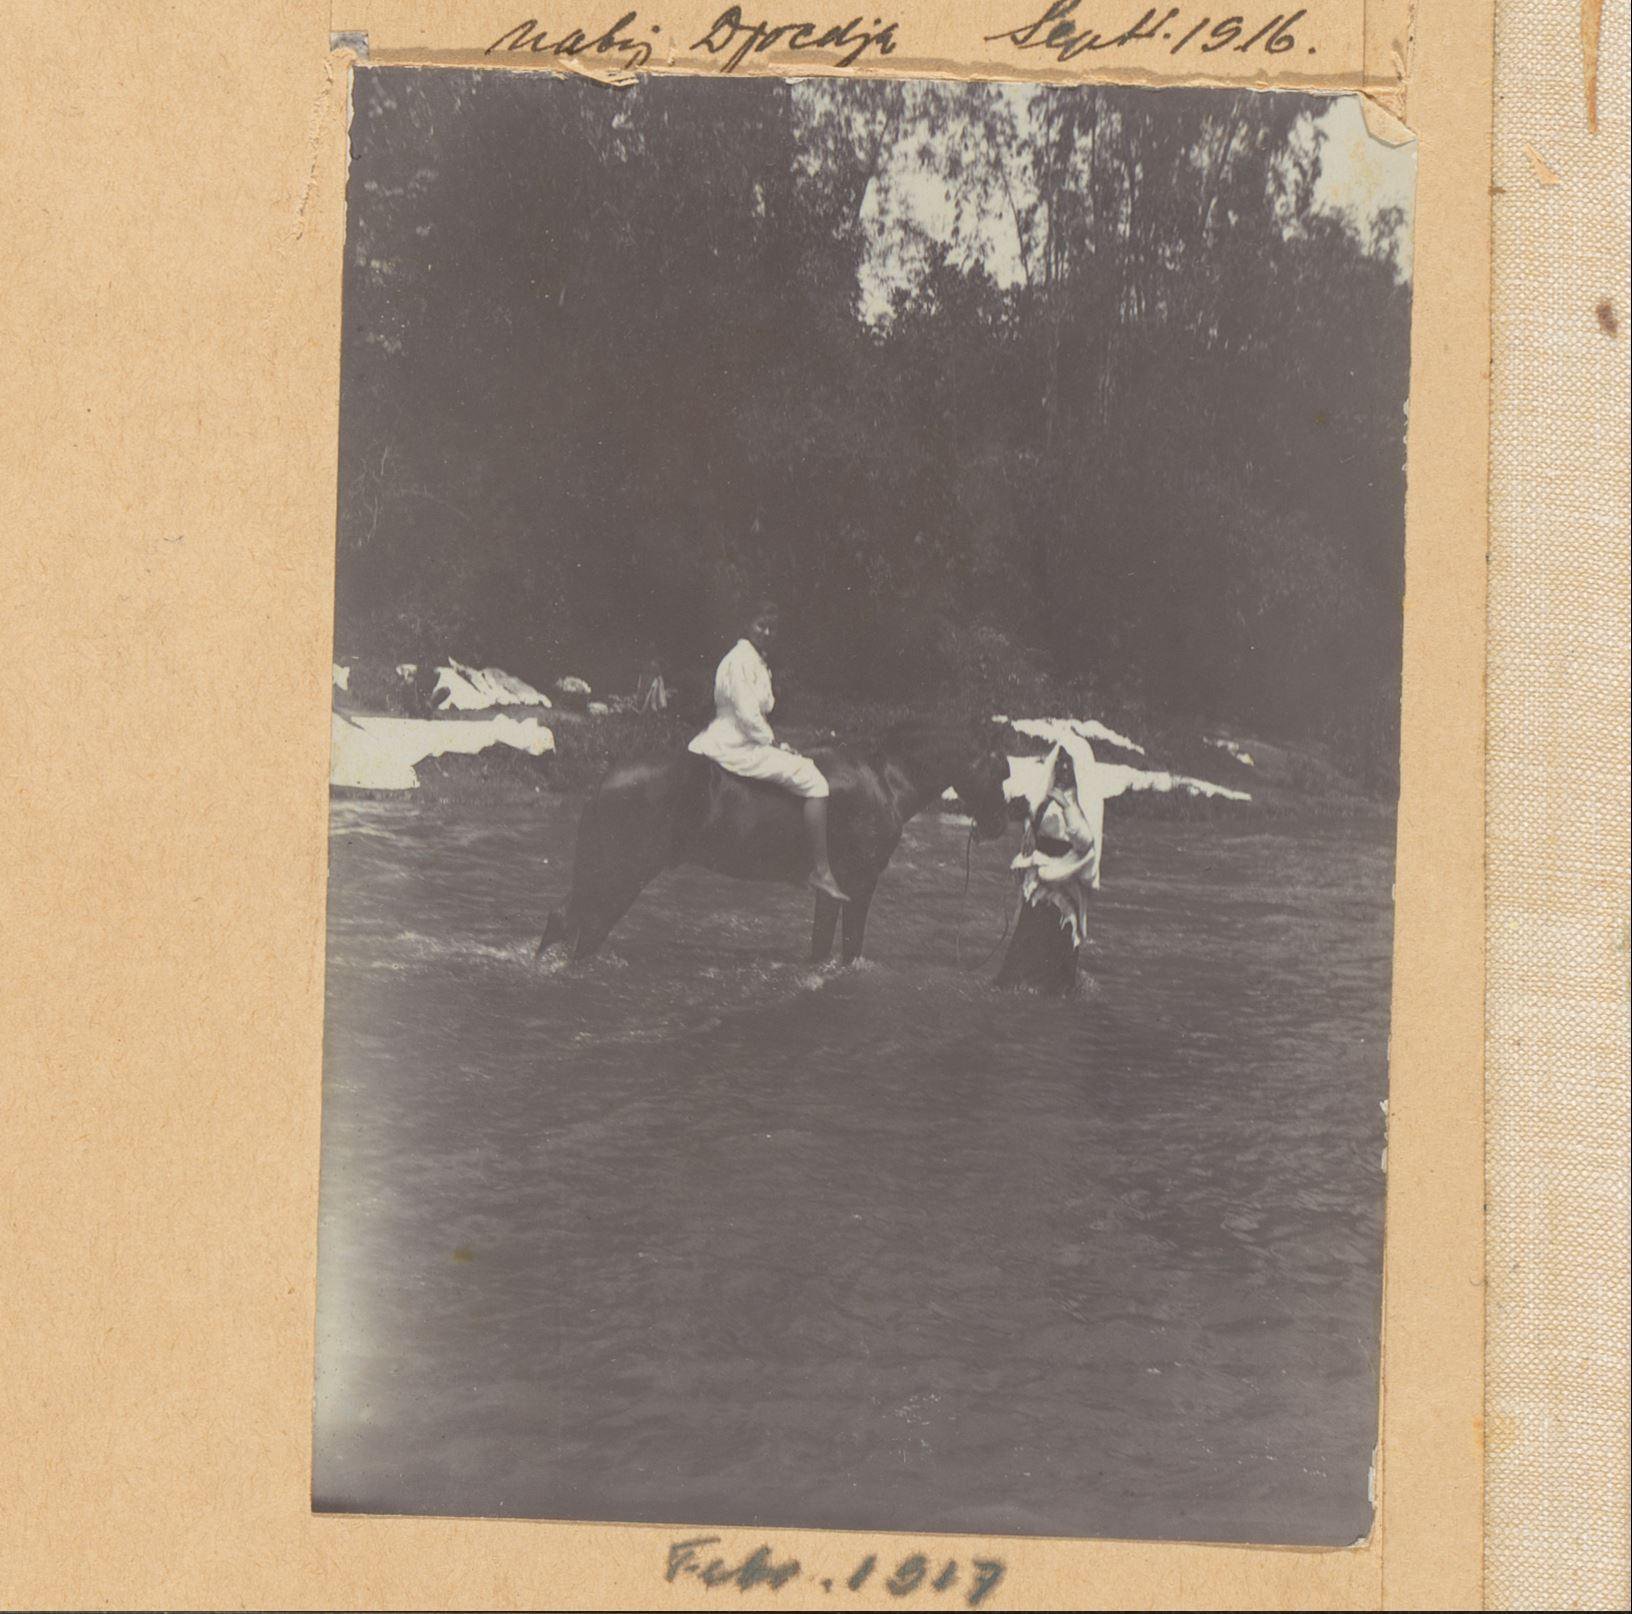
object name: photograph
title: Meisje te paard en begeleider in een rivier in Nederlands-Indië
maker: Anonymous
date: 1902-1917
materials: photographic support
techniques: gelatin silver print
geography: dutch east indies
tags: riding a horse, ass, or mule; rider, horseman, river (+ landscape with figures, staffage), dutch east indies, the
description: Onderdeel van Familiealbum met foto's van een familie in de voormalige kolonie Nederlands-Indië en van een suikerfabriek in Purworejo.